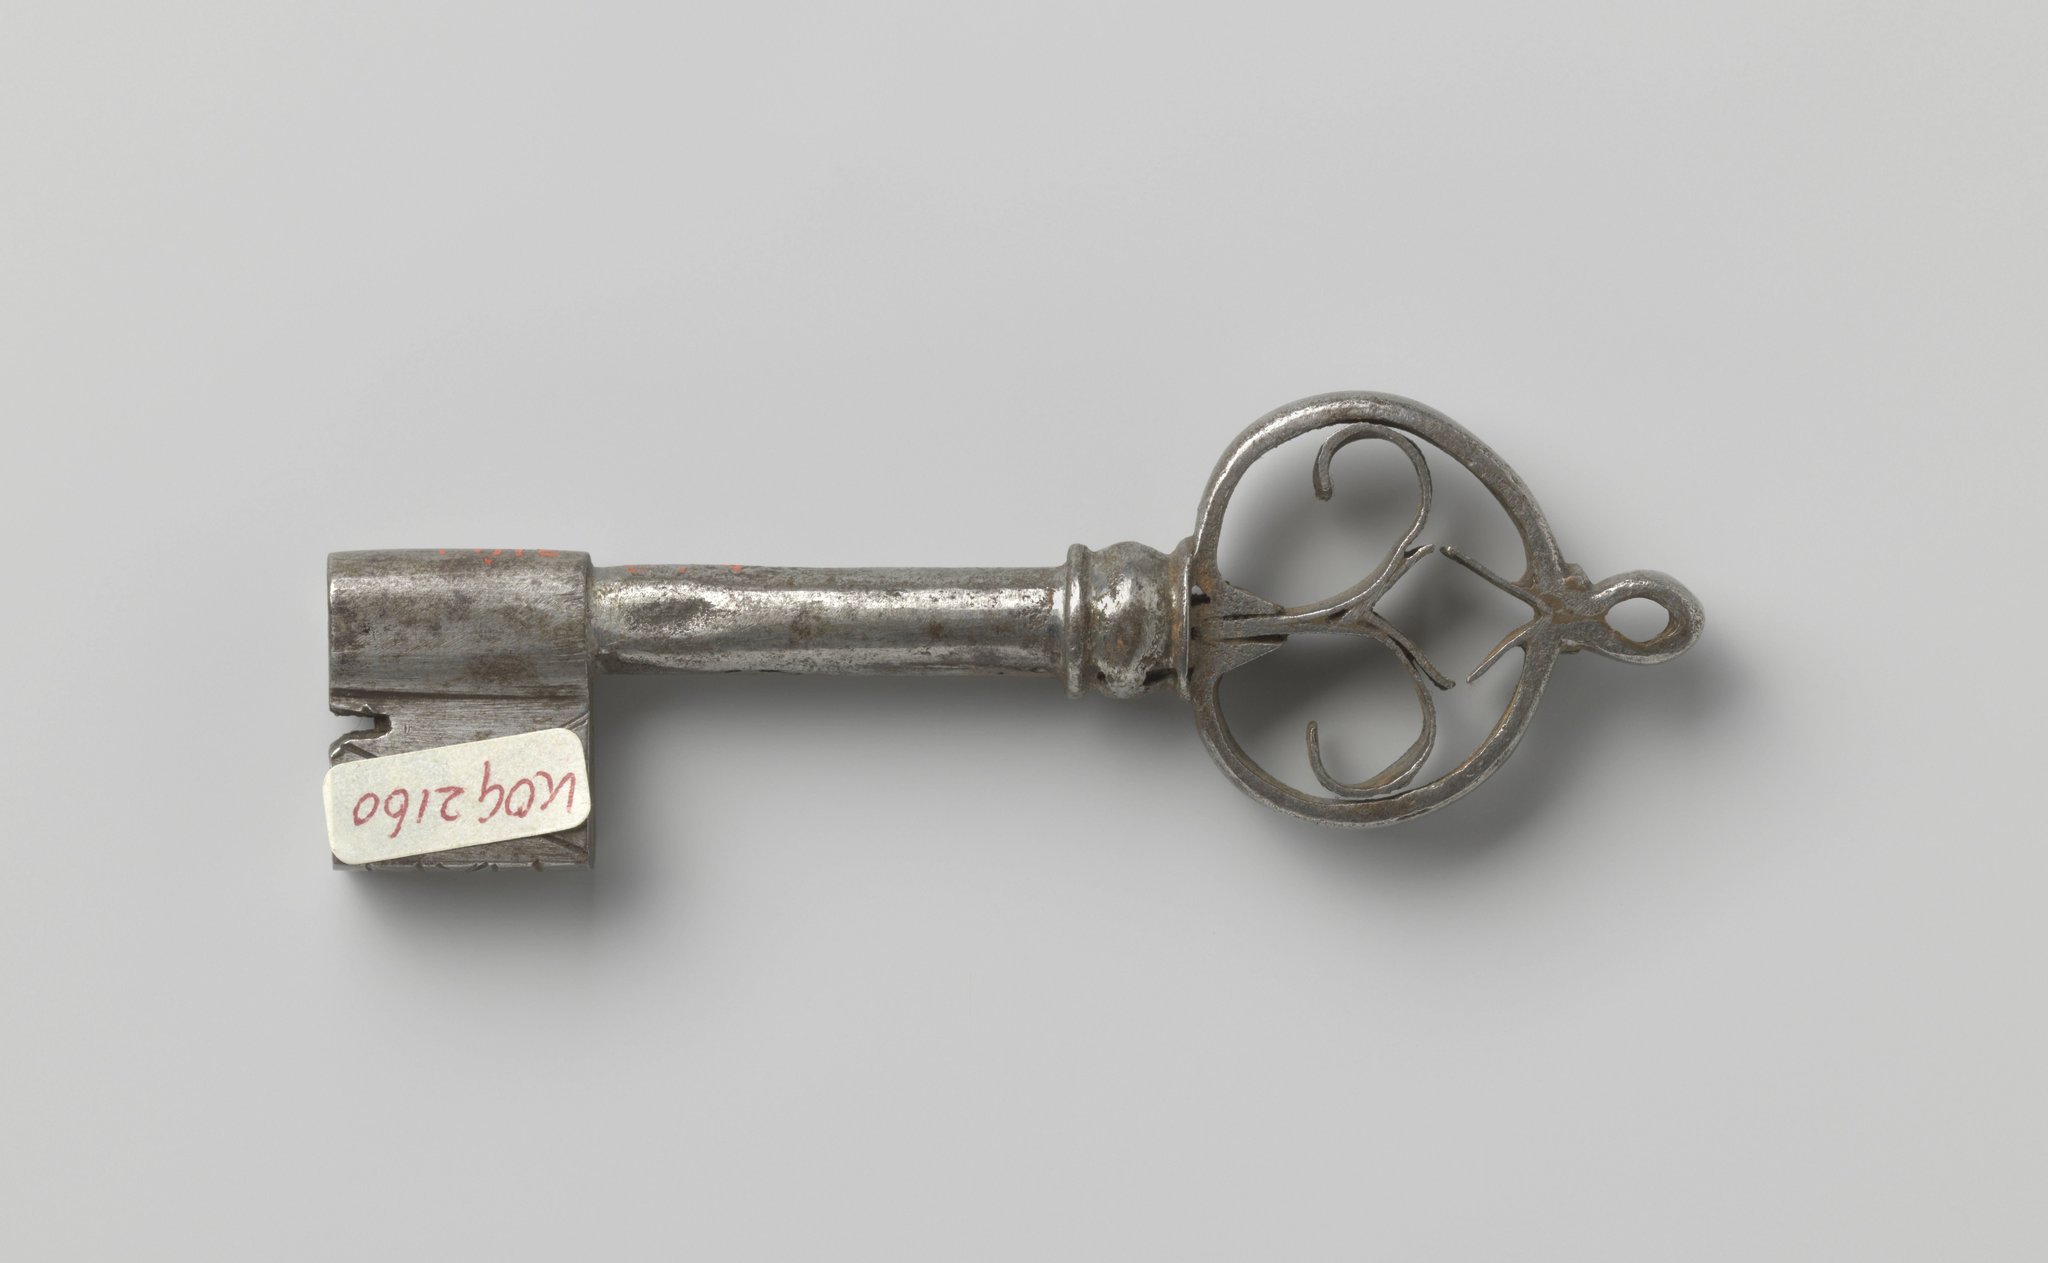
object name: pipe key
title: Pijpsleutel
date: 1500-1525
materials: iron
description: Pijpsleutel waarbij de greep ontstaan is door samensnoering van een band tot een groot en een klein oog. In het grote oog ontspringt een lelie. De massieve baard die om de schacht heen gesmeed is, heeft aan beide zijden een ingegroefd Andreaskruis. De lelie is geschonden; de baard van later datum (?).